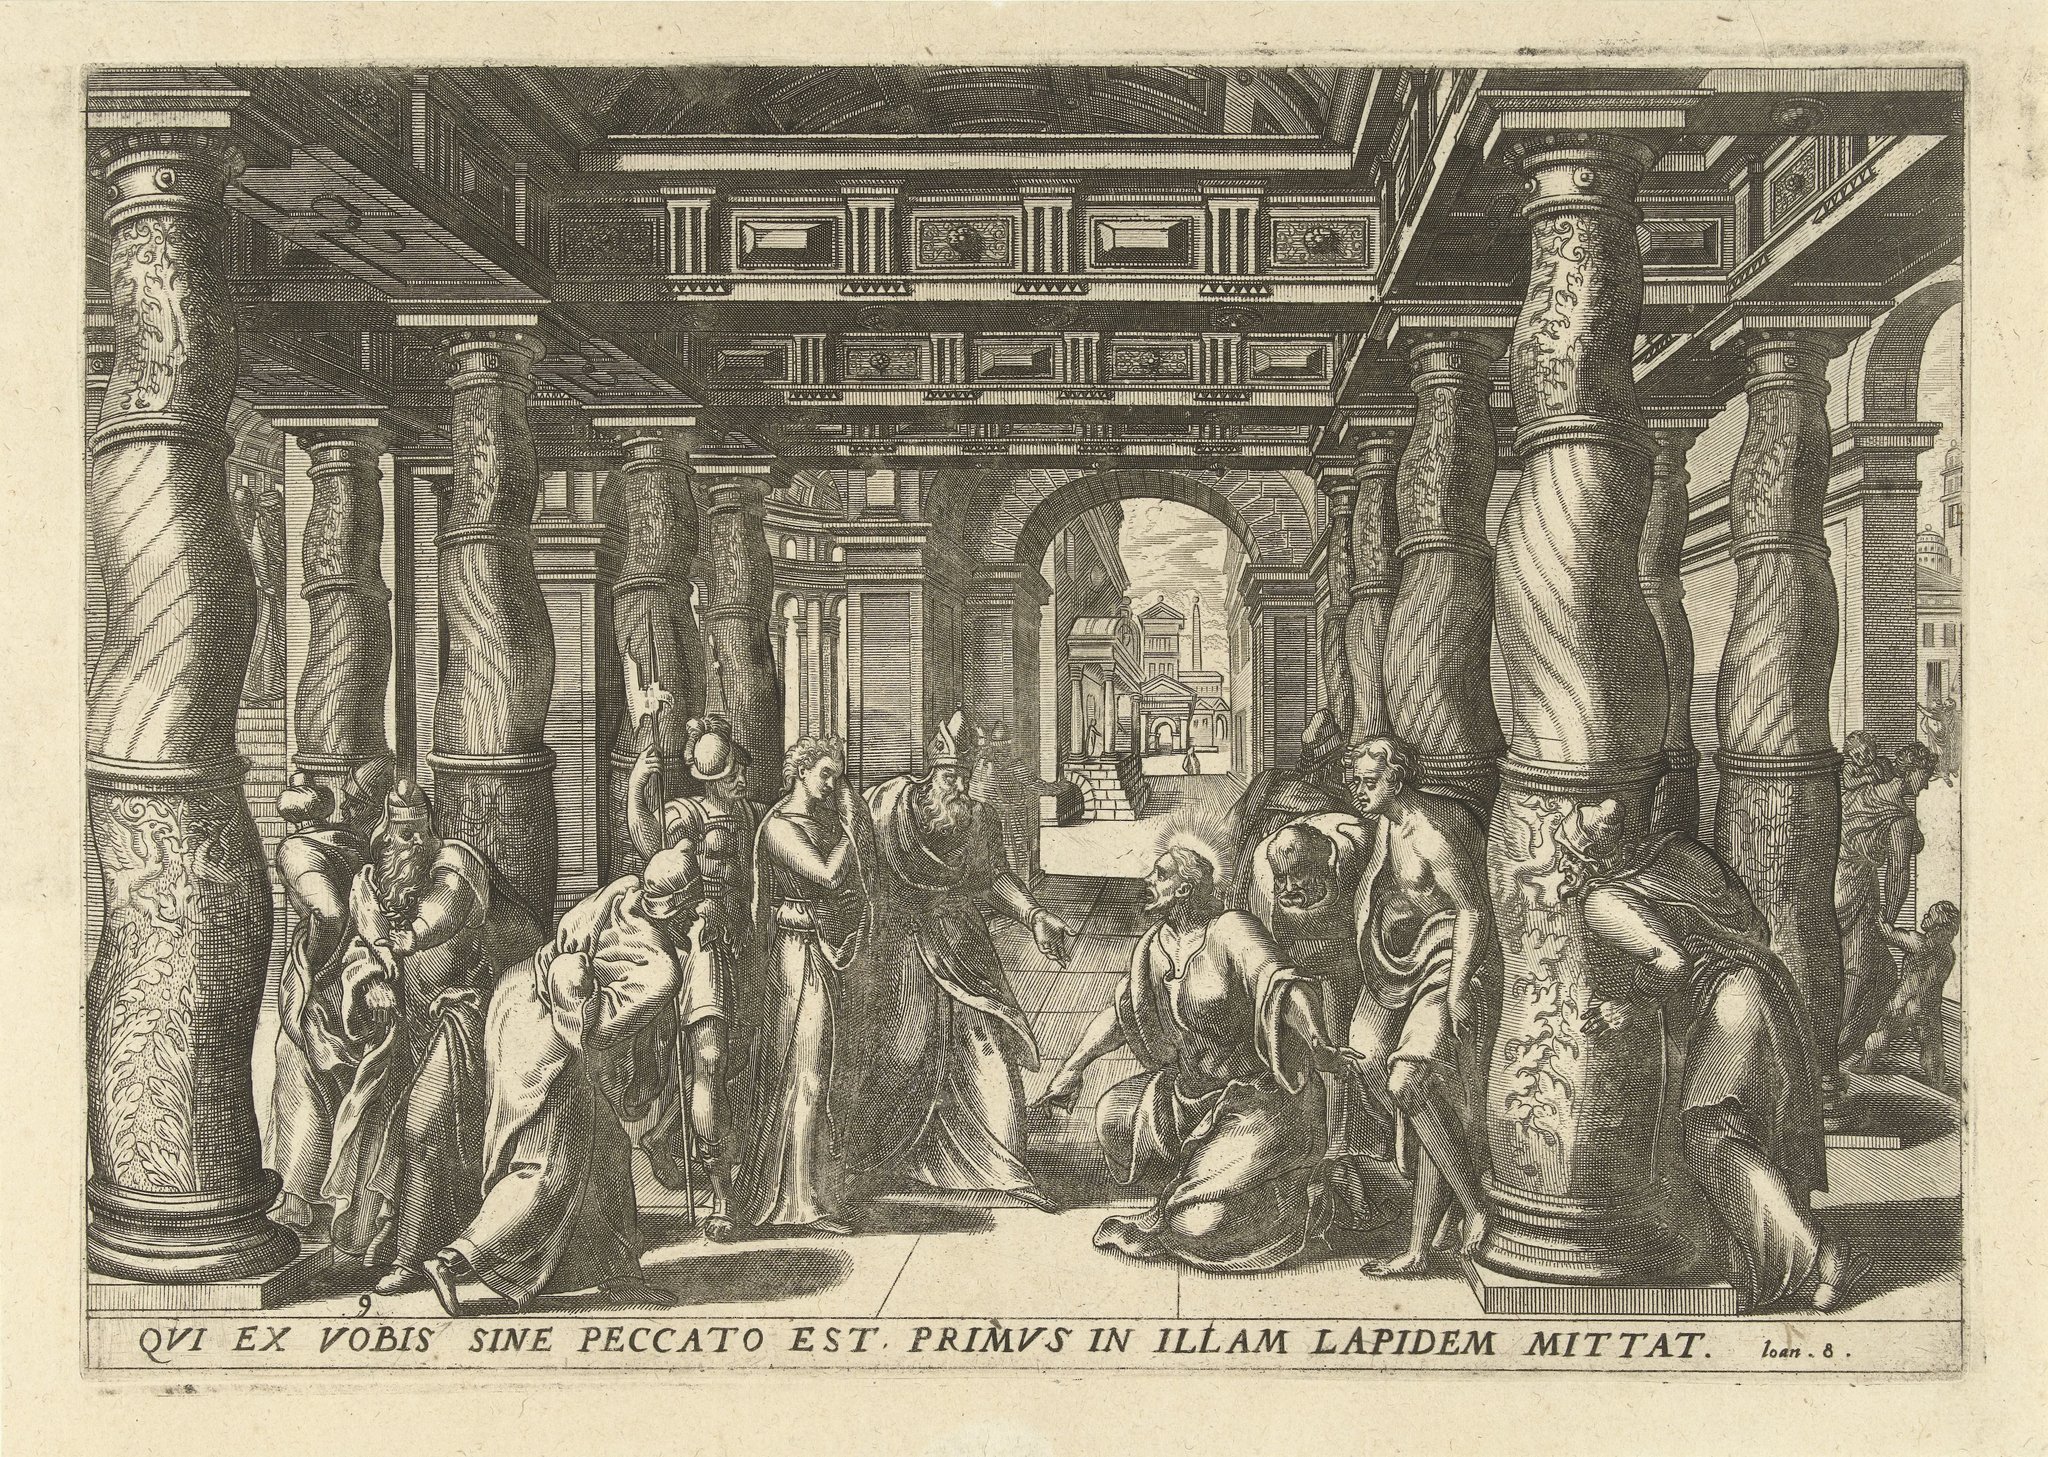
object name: print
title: Christus en de overspelige vrouw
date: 1572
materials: paper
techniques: engraving, etching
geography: antwerp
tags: pharisees bring a woman accused of adultery before christ (john 8:2-11)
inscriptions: collector's mark: Lugt 2228, collector's mark: Lugt 2760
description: De schriftgeleerden brengen een overspelige vrouw naar Christus in de tempel. Ze vragen hem om haar te veroordelen. Hij antwoord: 'Wie van jullie zonder zonde is laat die als eerste een steen naar haar werpen'.